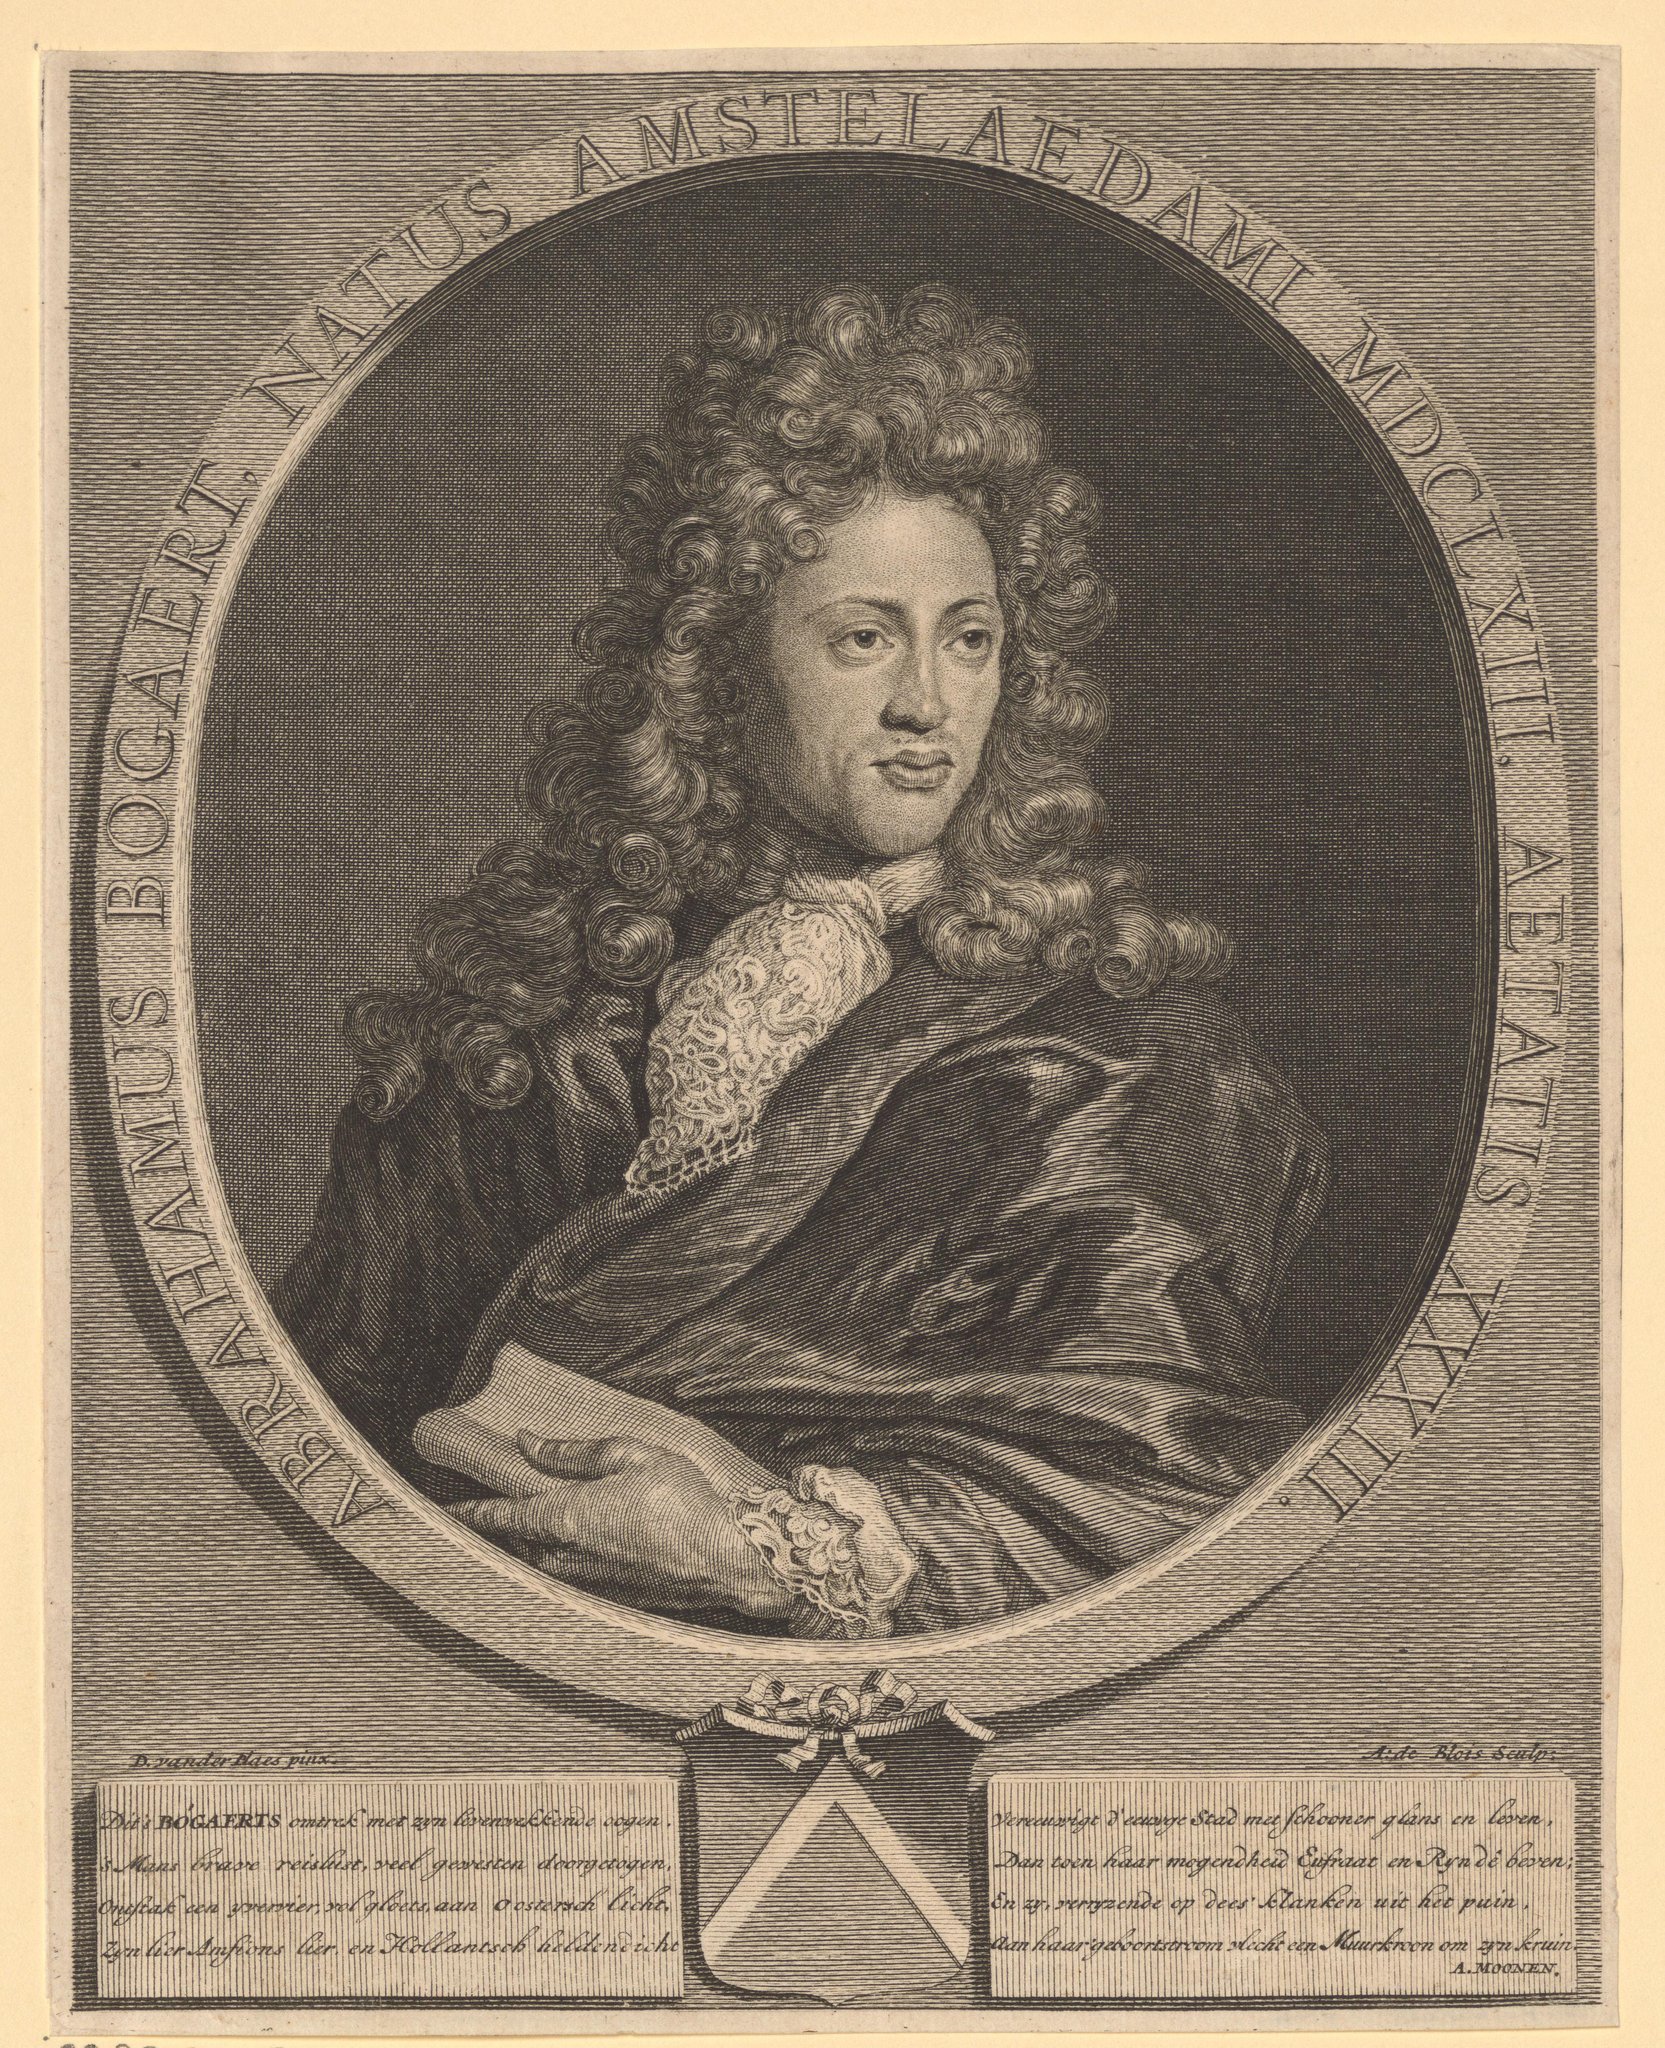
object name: print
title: Abrahamus Bogaert, natus Amstelaedami (...)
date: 1686-1717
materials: paper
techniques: engraving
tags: amsterdam, abraham bogaert, historical persons, portrait of a writer, armorial bearing, heraldry